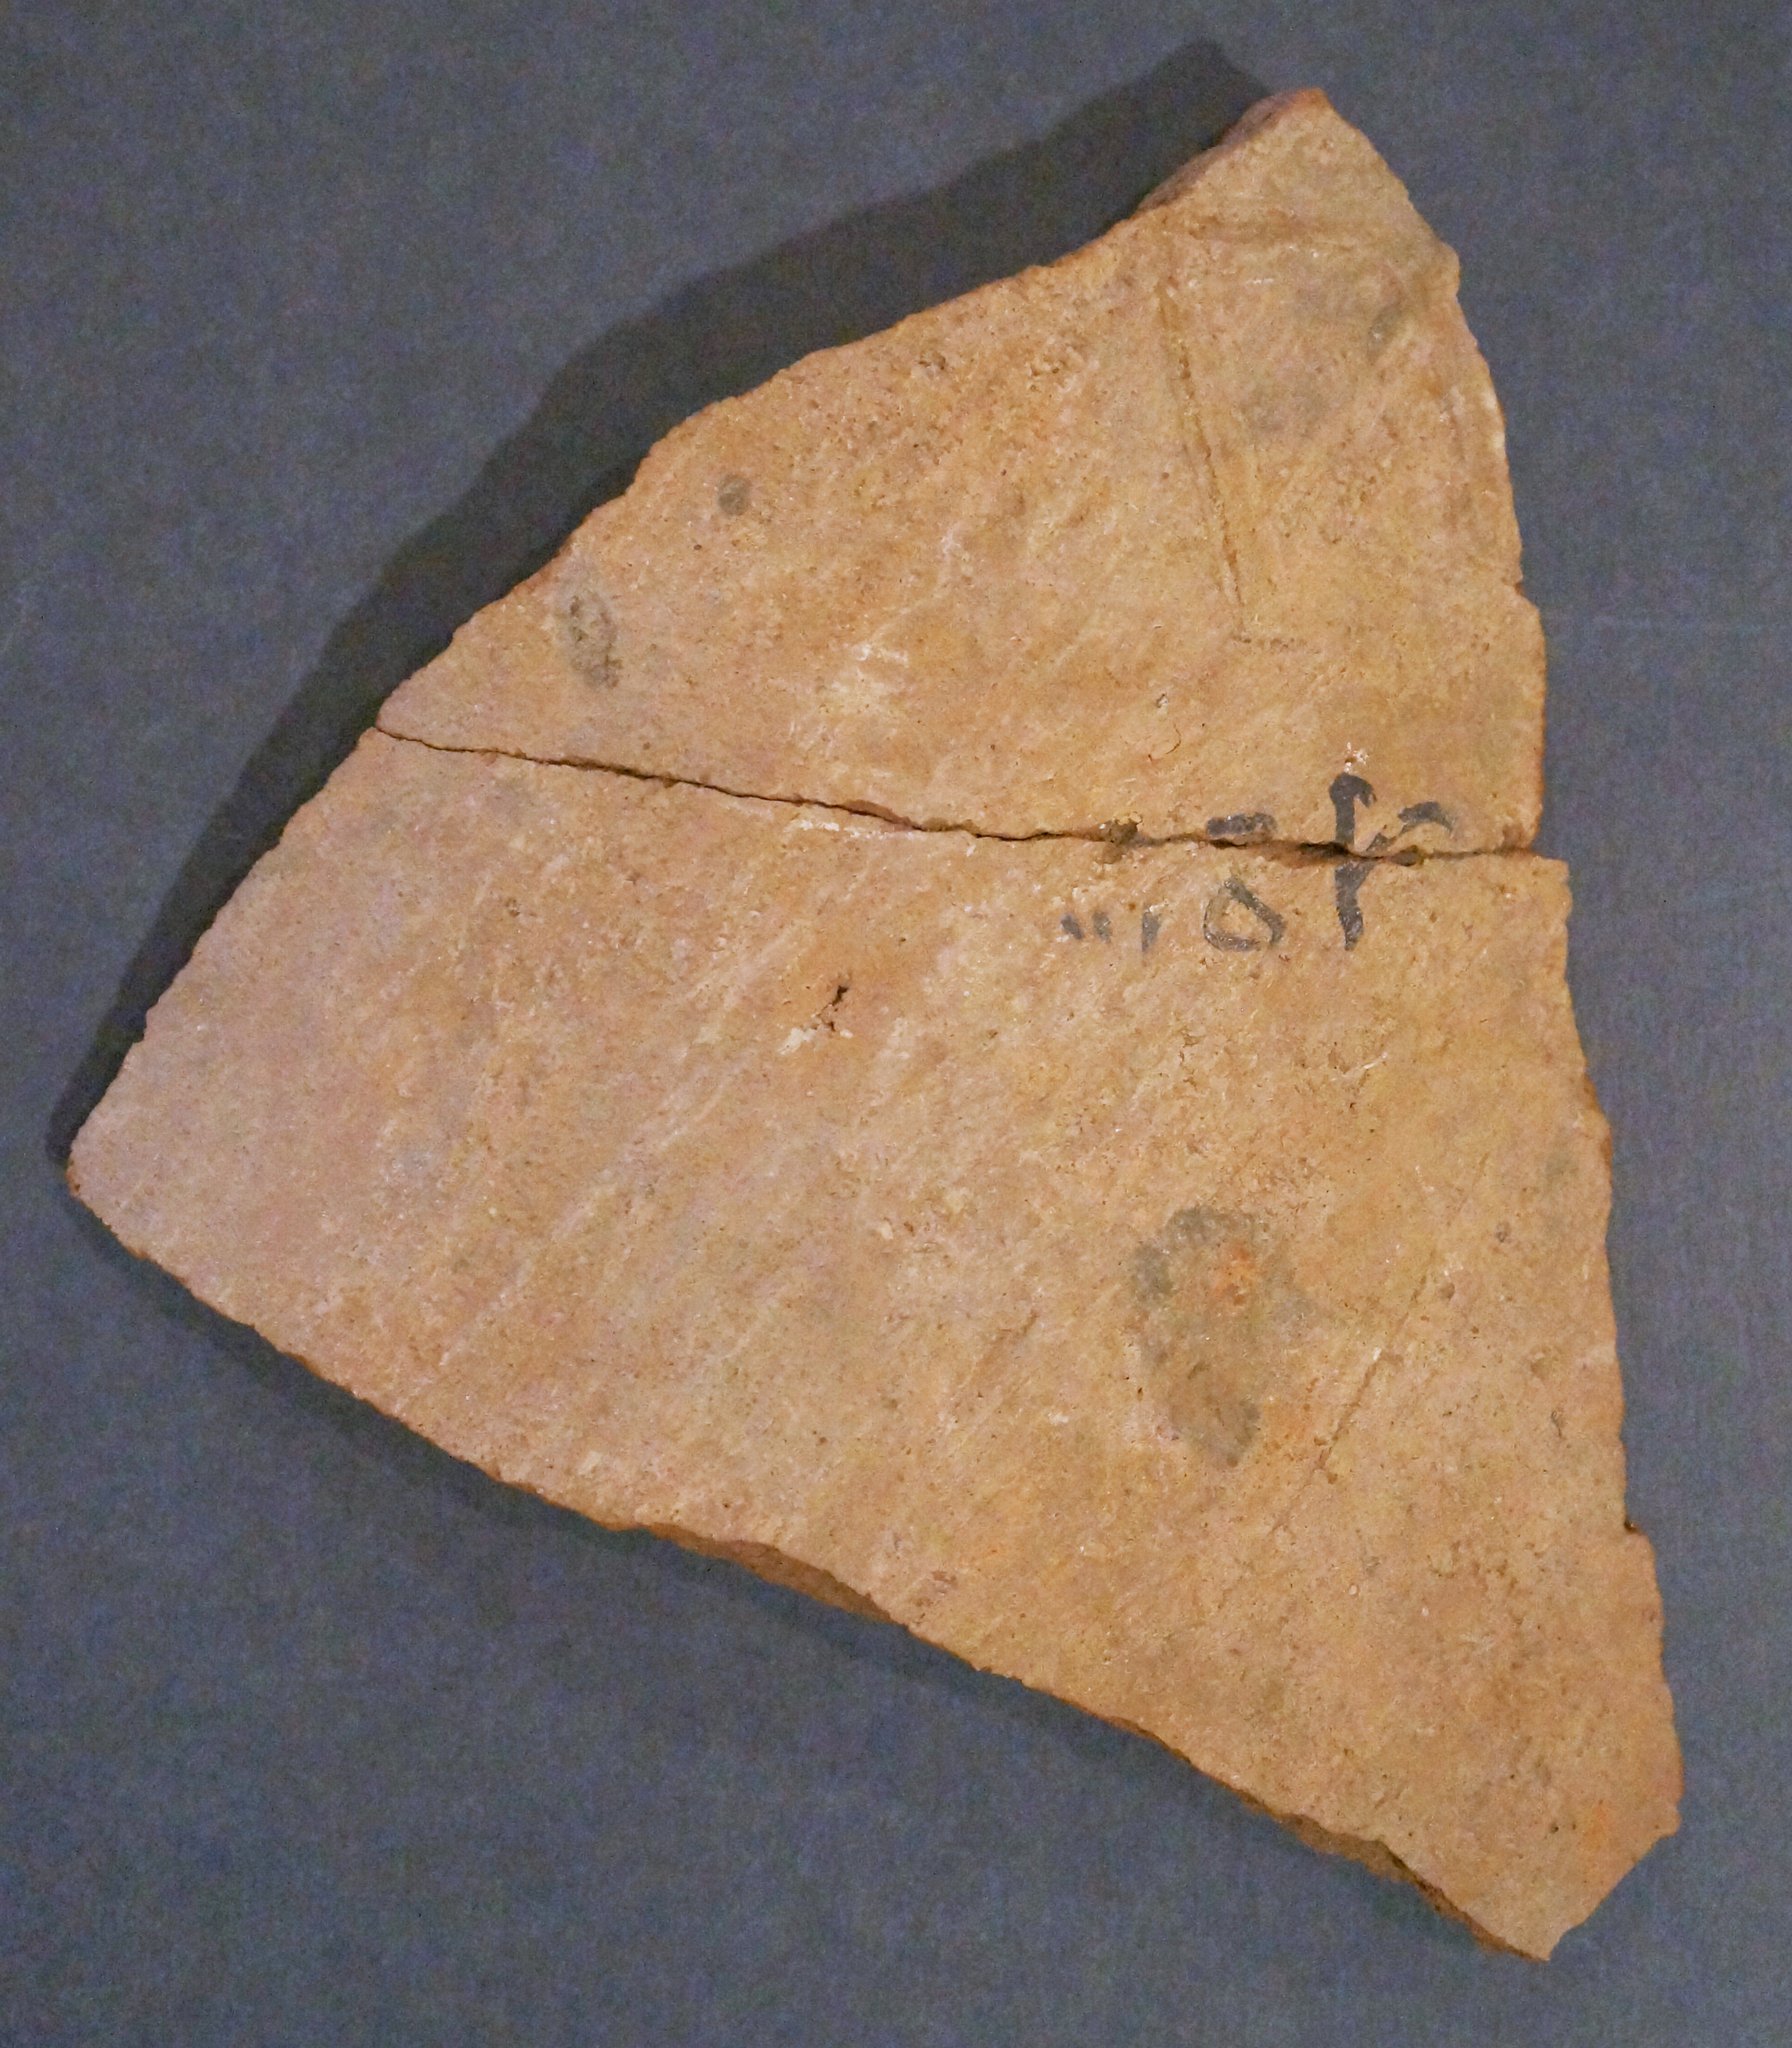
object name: jar label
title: Inscribed Pot Fragment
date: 1580-1479 BCE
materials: ink, pottery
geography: egypt